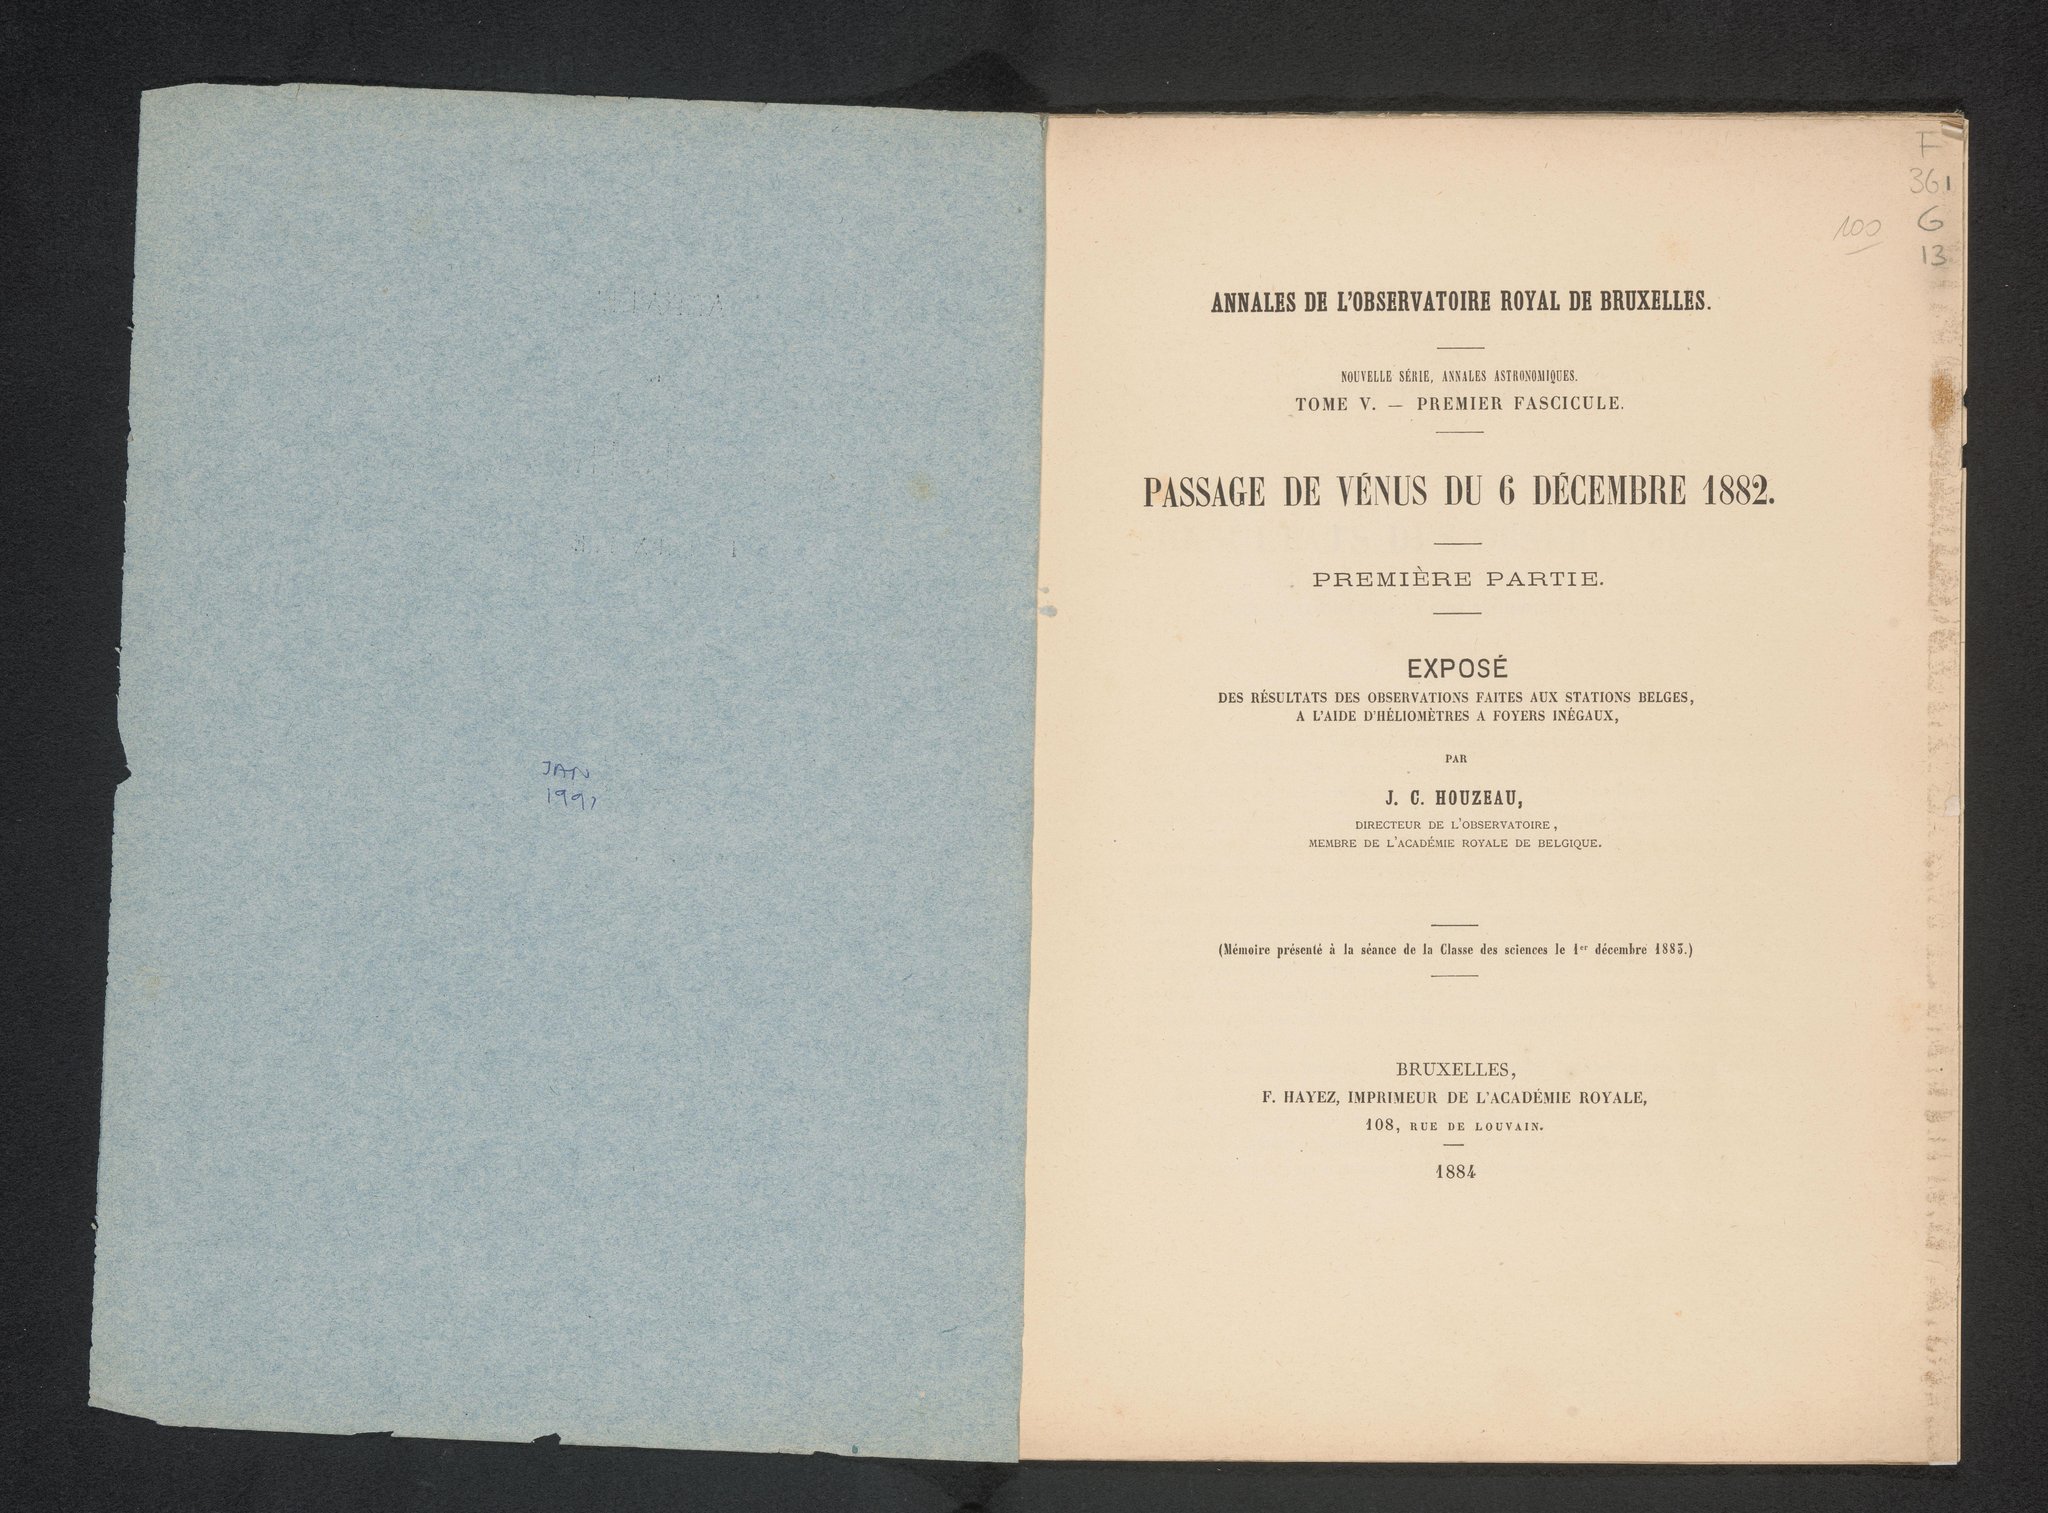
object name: book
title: Annales de l'Observatoire royal de Bruxelles. Annales astronomiques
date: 1884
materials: paper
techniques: photograph, lithograph, printing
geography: brussels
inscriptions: bookplate: ‘BIBLIOTHECA/ BRUXELL’, number: ‘317’, date: ‘JAN/ 1991’, number: ‘100’